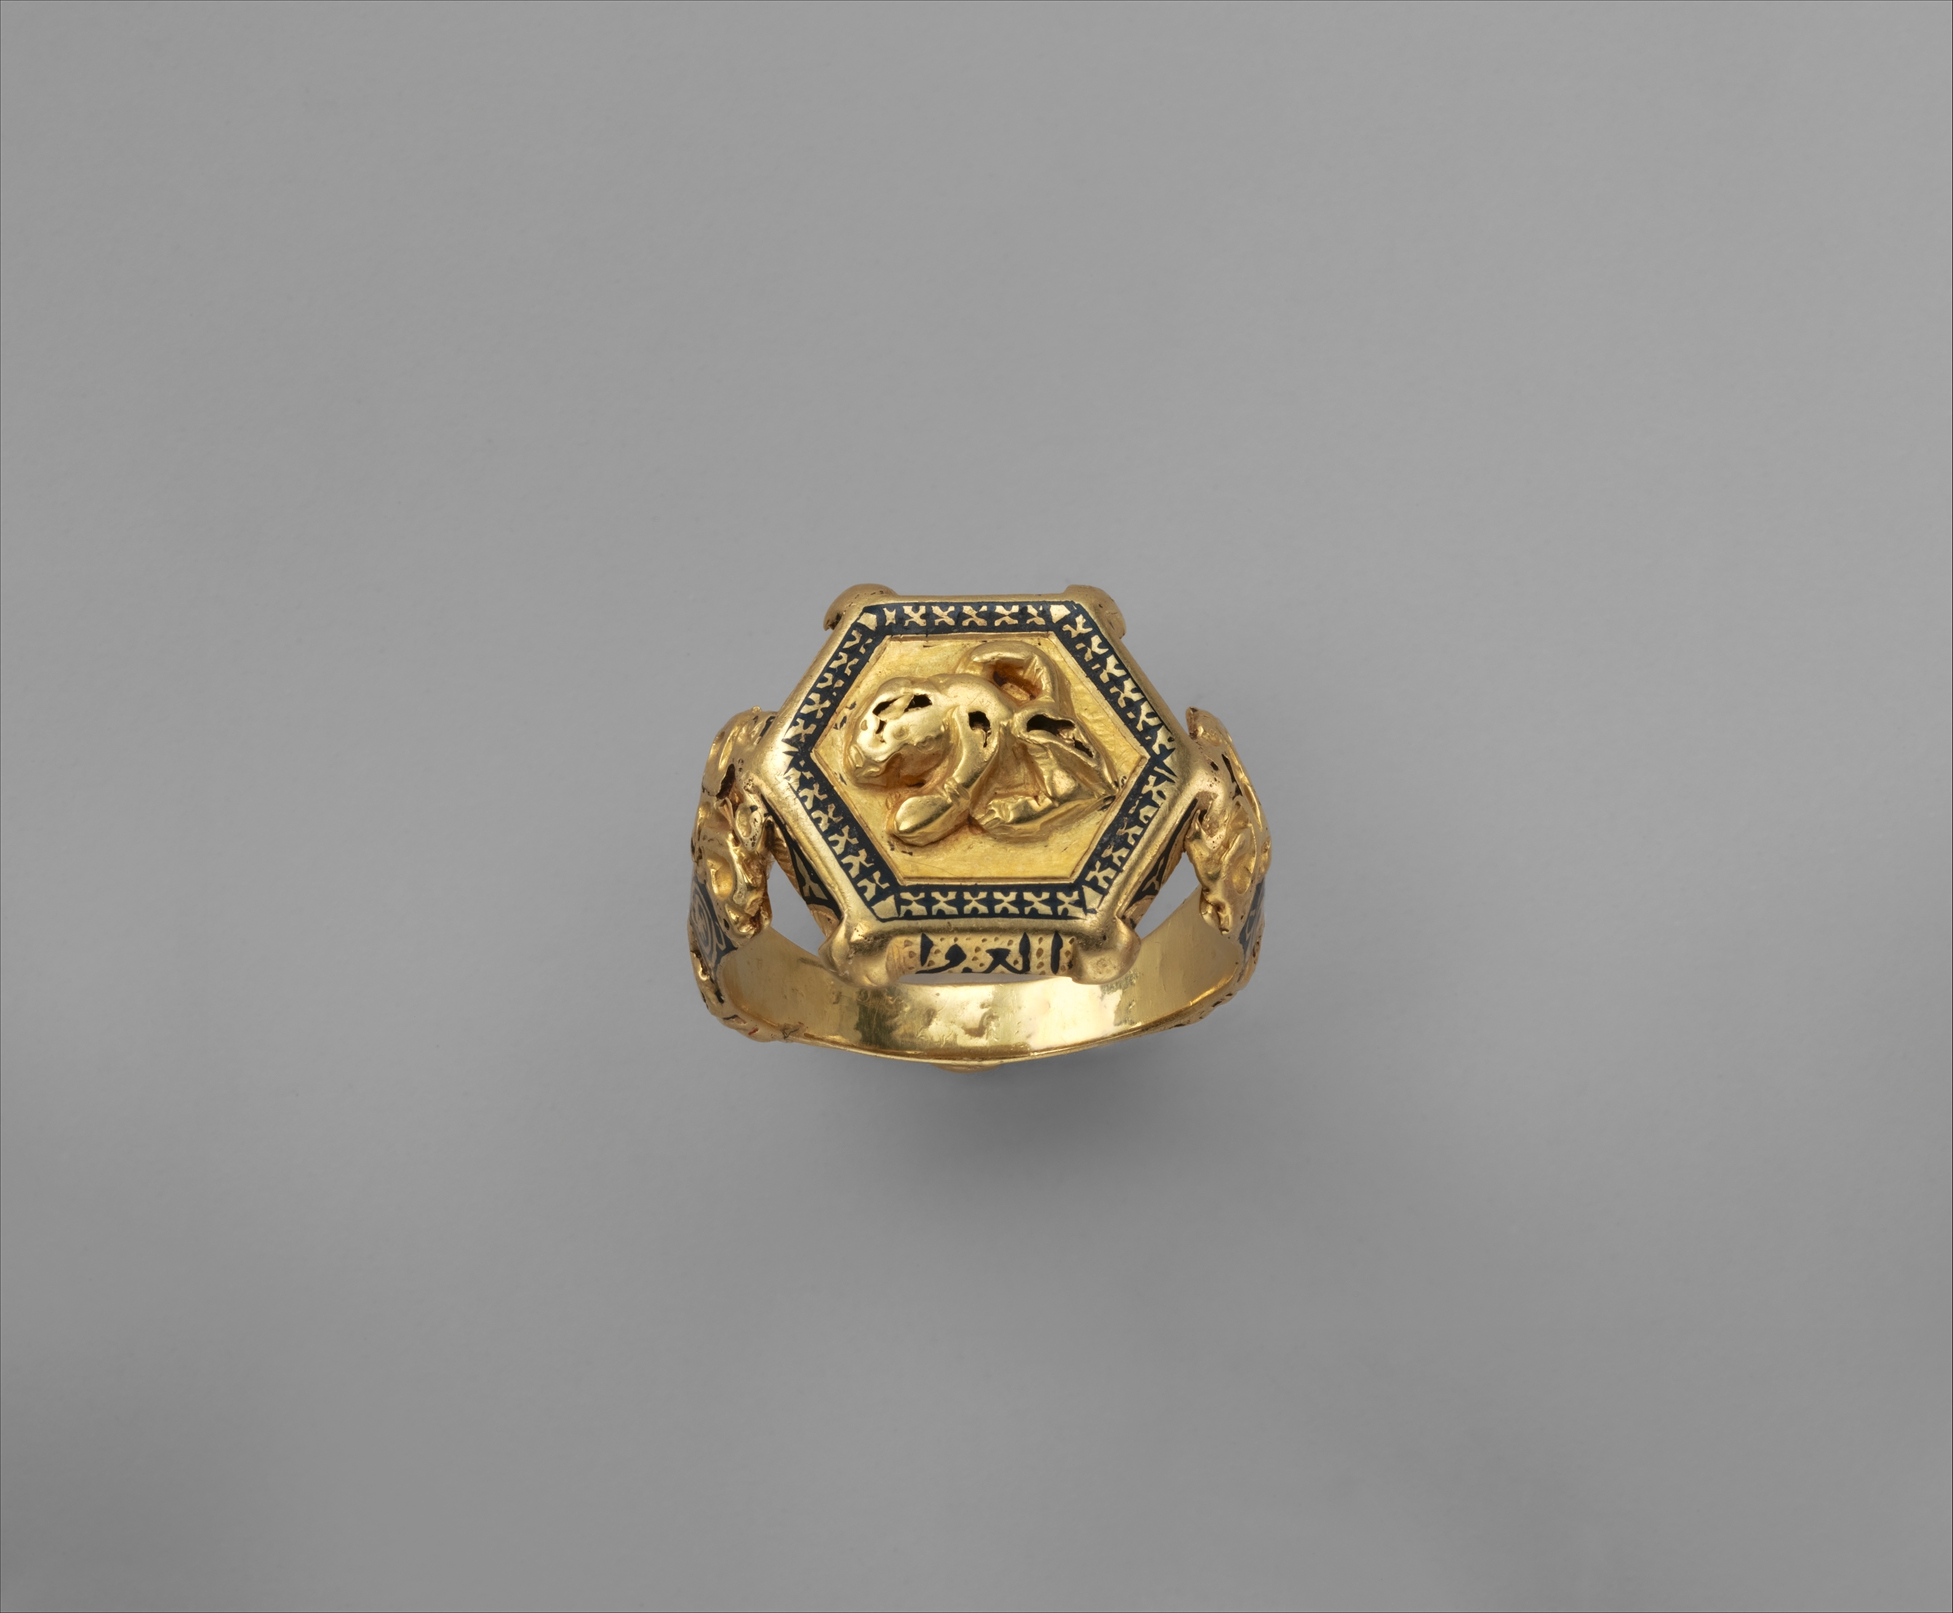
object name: ring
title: Ring with Seated Lion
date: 1101-1200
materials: gold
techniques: inlay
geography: iran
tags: lions